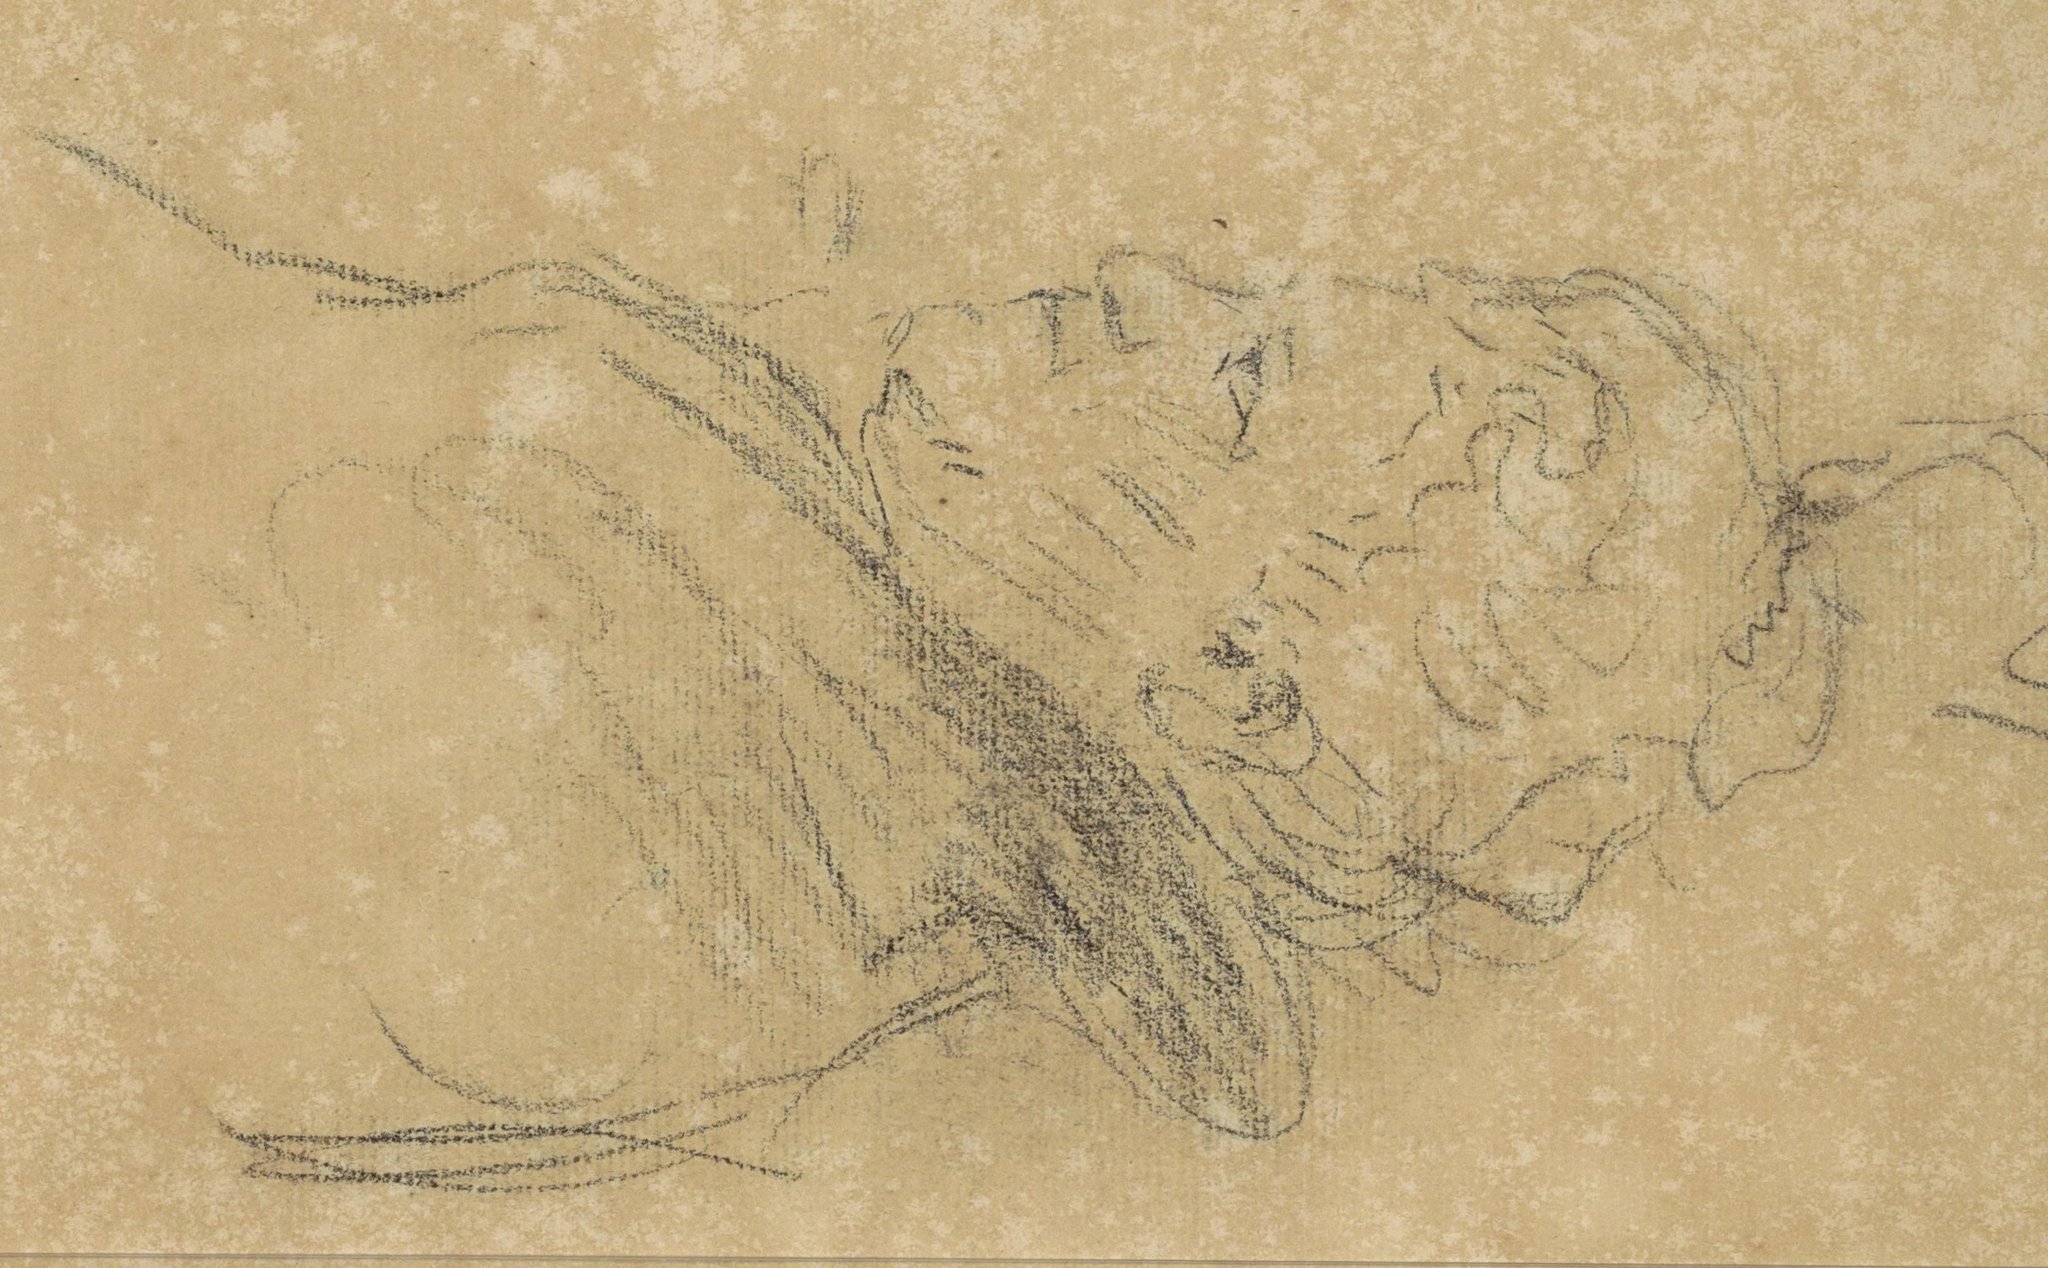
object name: sketchbook leaf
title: Oude vrouw met haardecoratie, in profiel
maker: isaac israels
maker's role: draughtsman, painter, print maker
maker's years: 1865-1934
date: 1886-1903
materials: chalk, paper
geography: amsterdam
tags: head-gear (+ women's clothes), old woman (+ sideview, profile)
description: Pagina 2 uit schetsboek XXXIII met 47 pagina's.